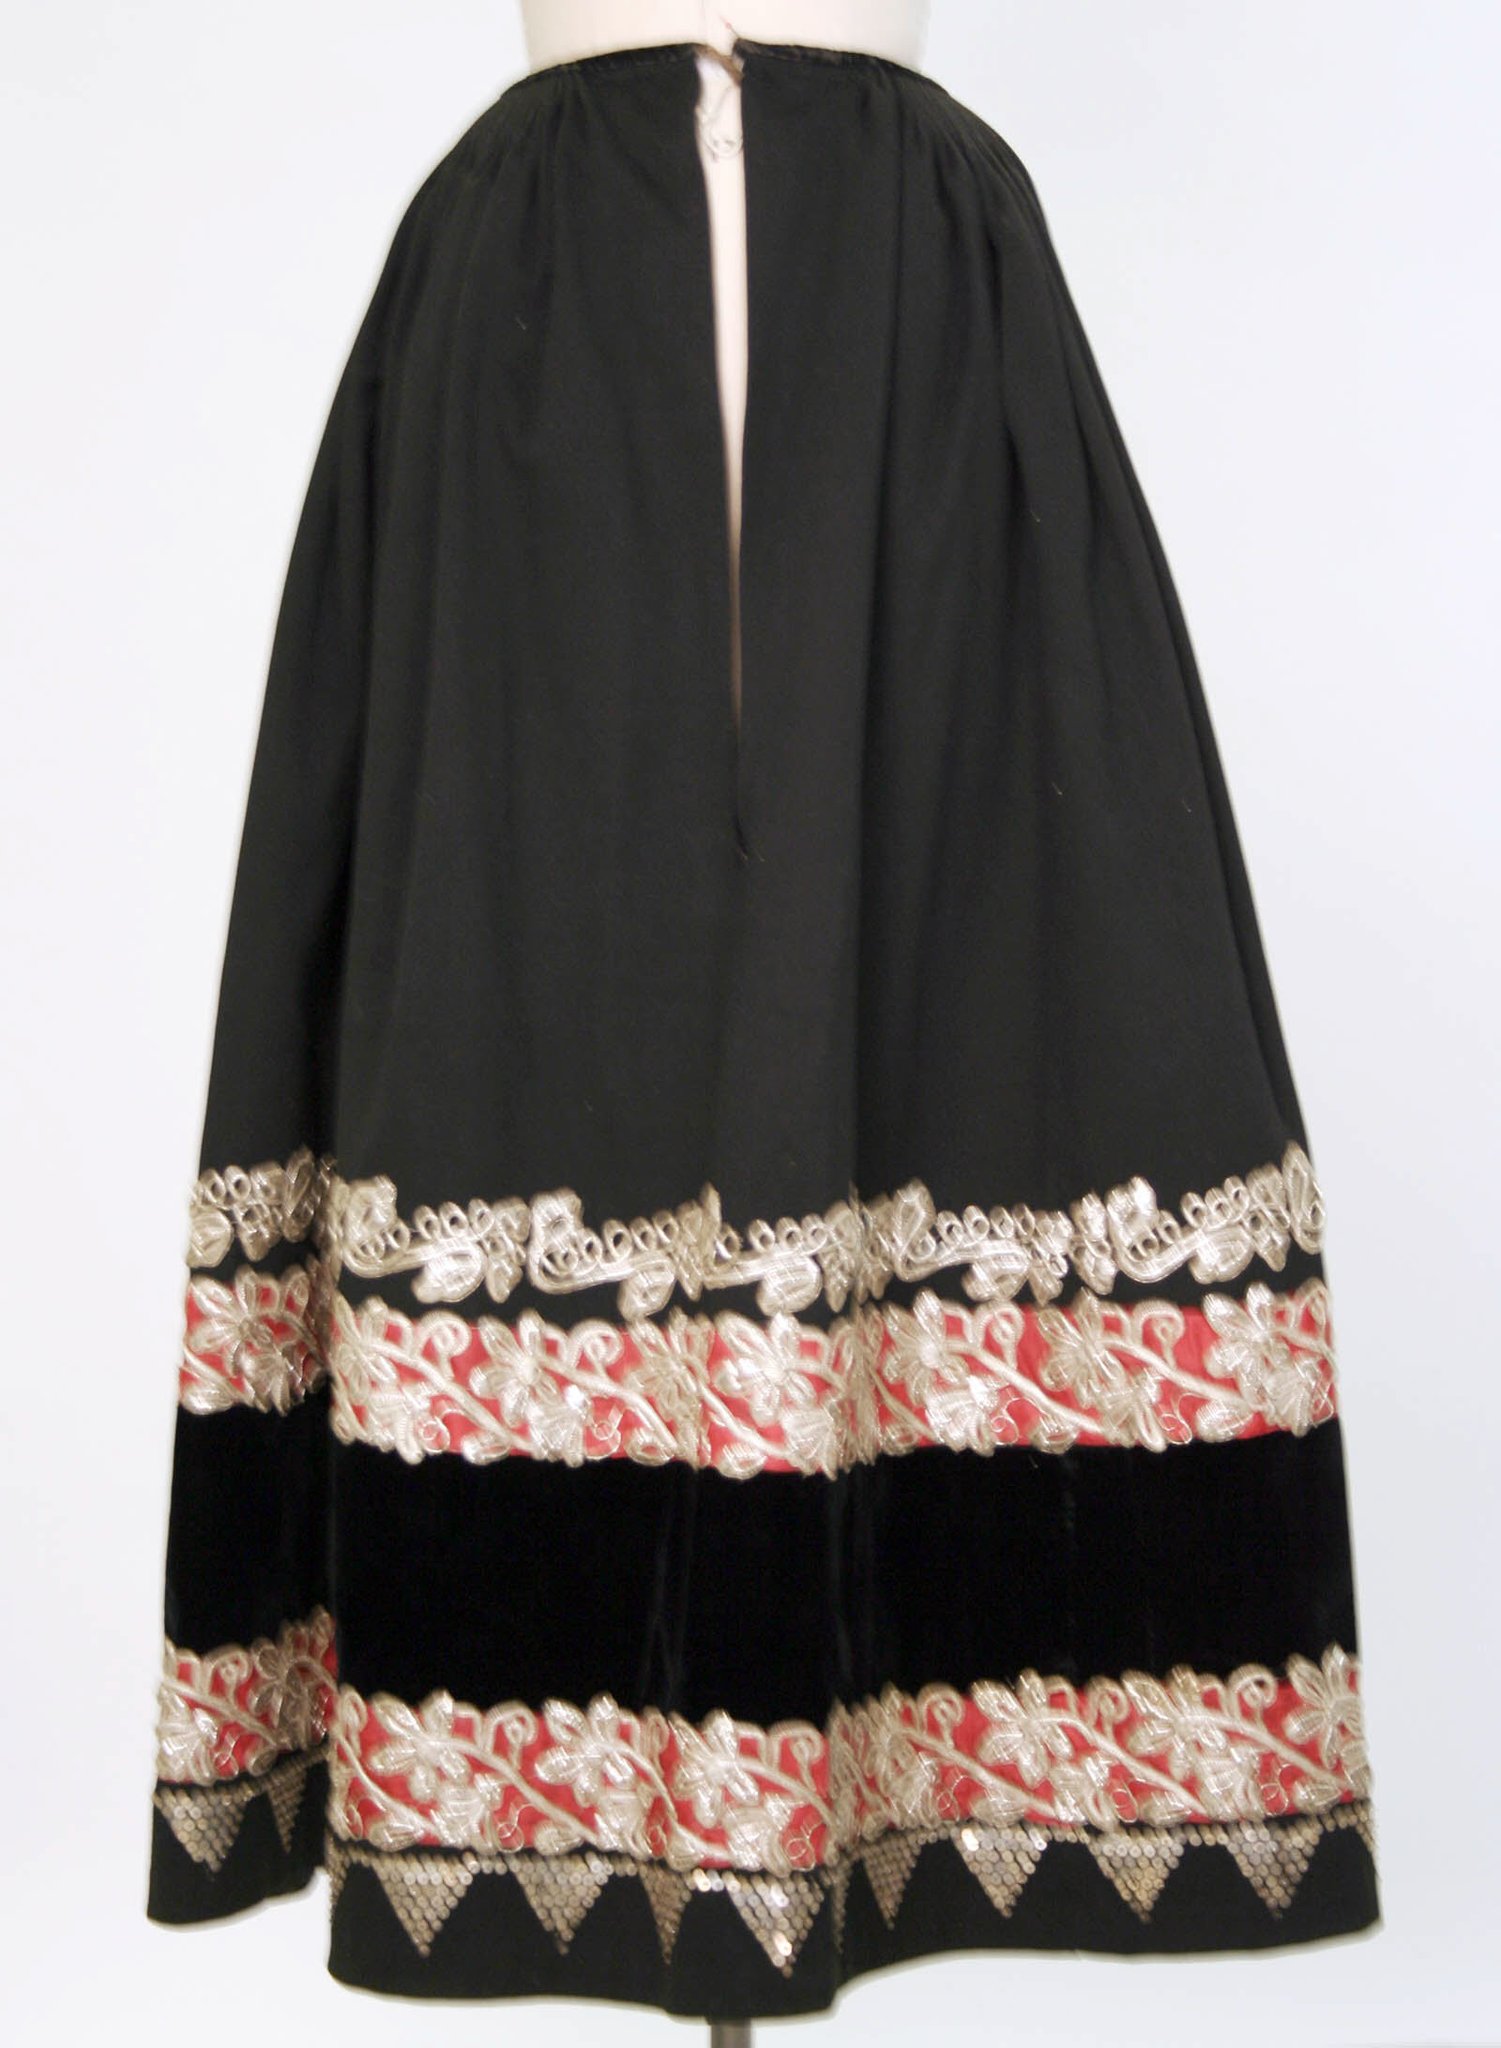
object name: skirt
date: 1801-1900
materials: glass, metal thread, thread, wool